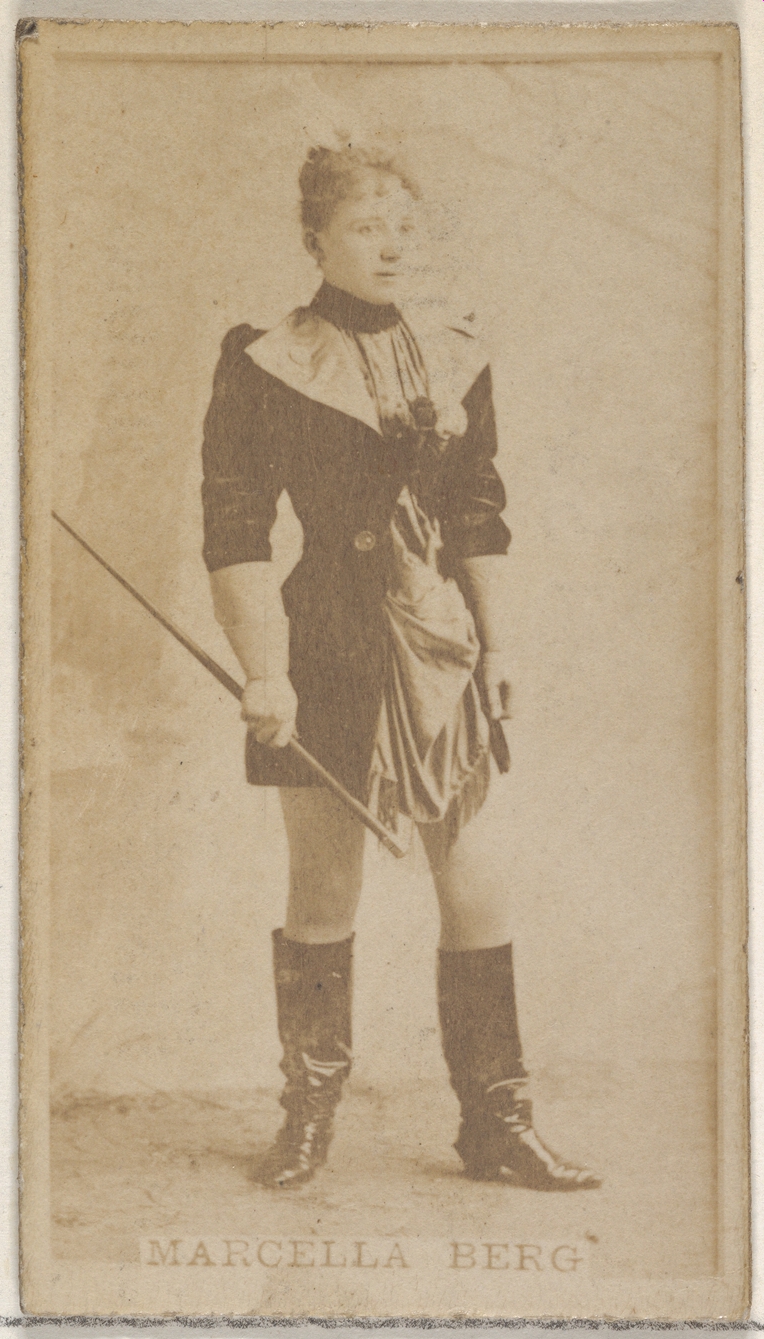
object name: photograph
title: Marcella Berg, from the Actors and Actresses series (N45, Type 8) for Virginia Brights Cigarettes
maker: allen & ginter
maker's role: publisher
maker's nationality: american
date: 1888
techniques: albumen silver print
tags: portraits,women,actresses